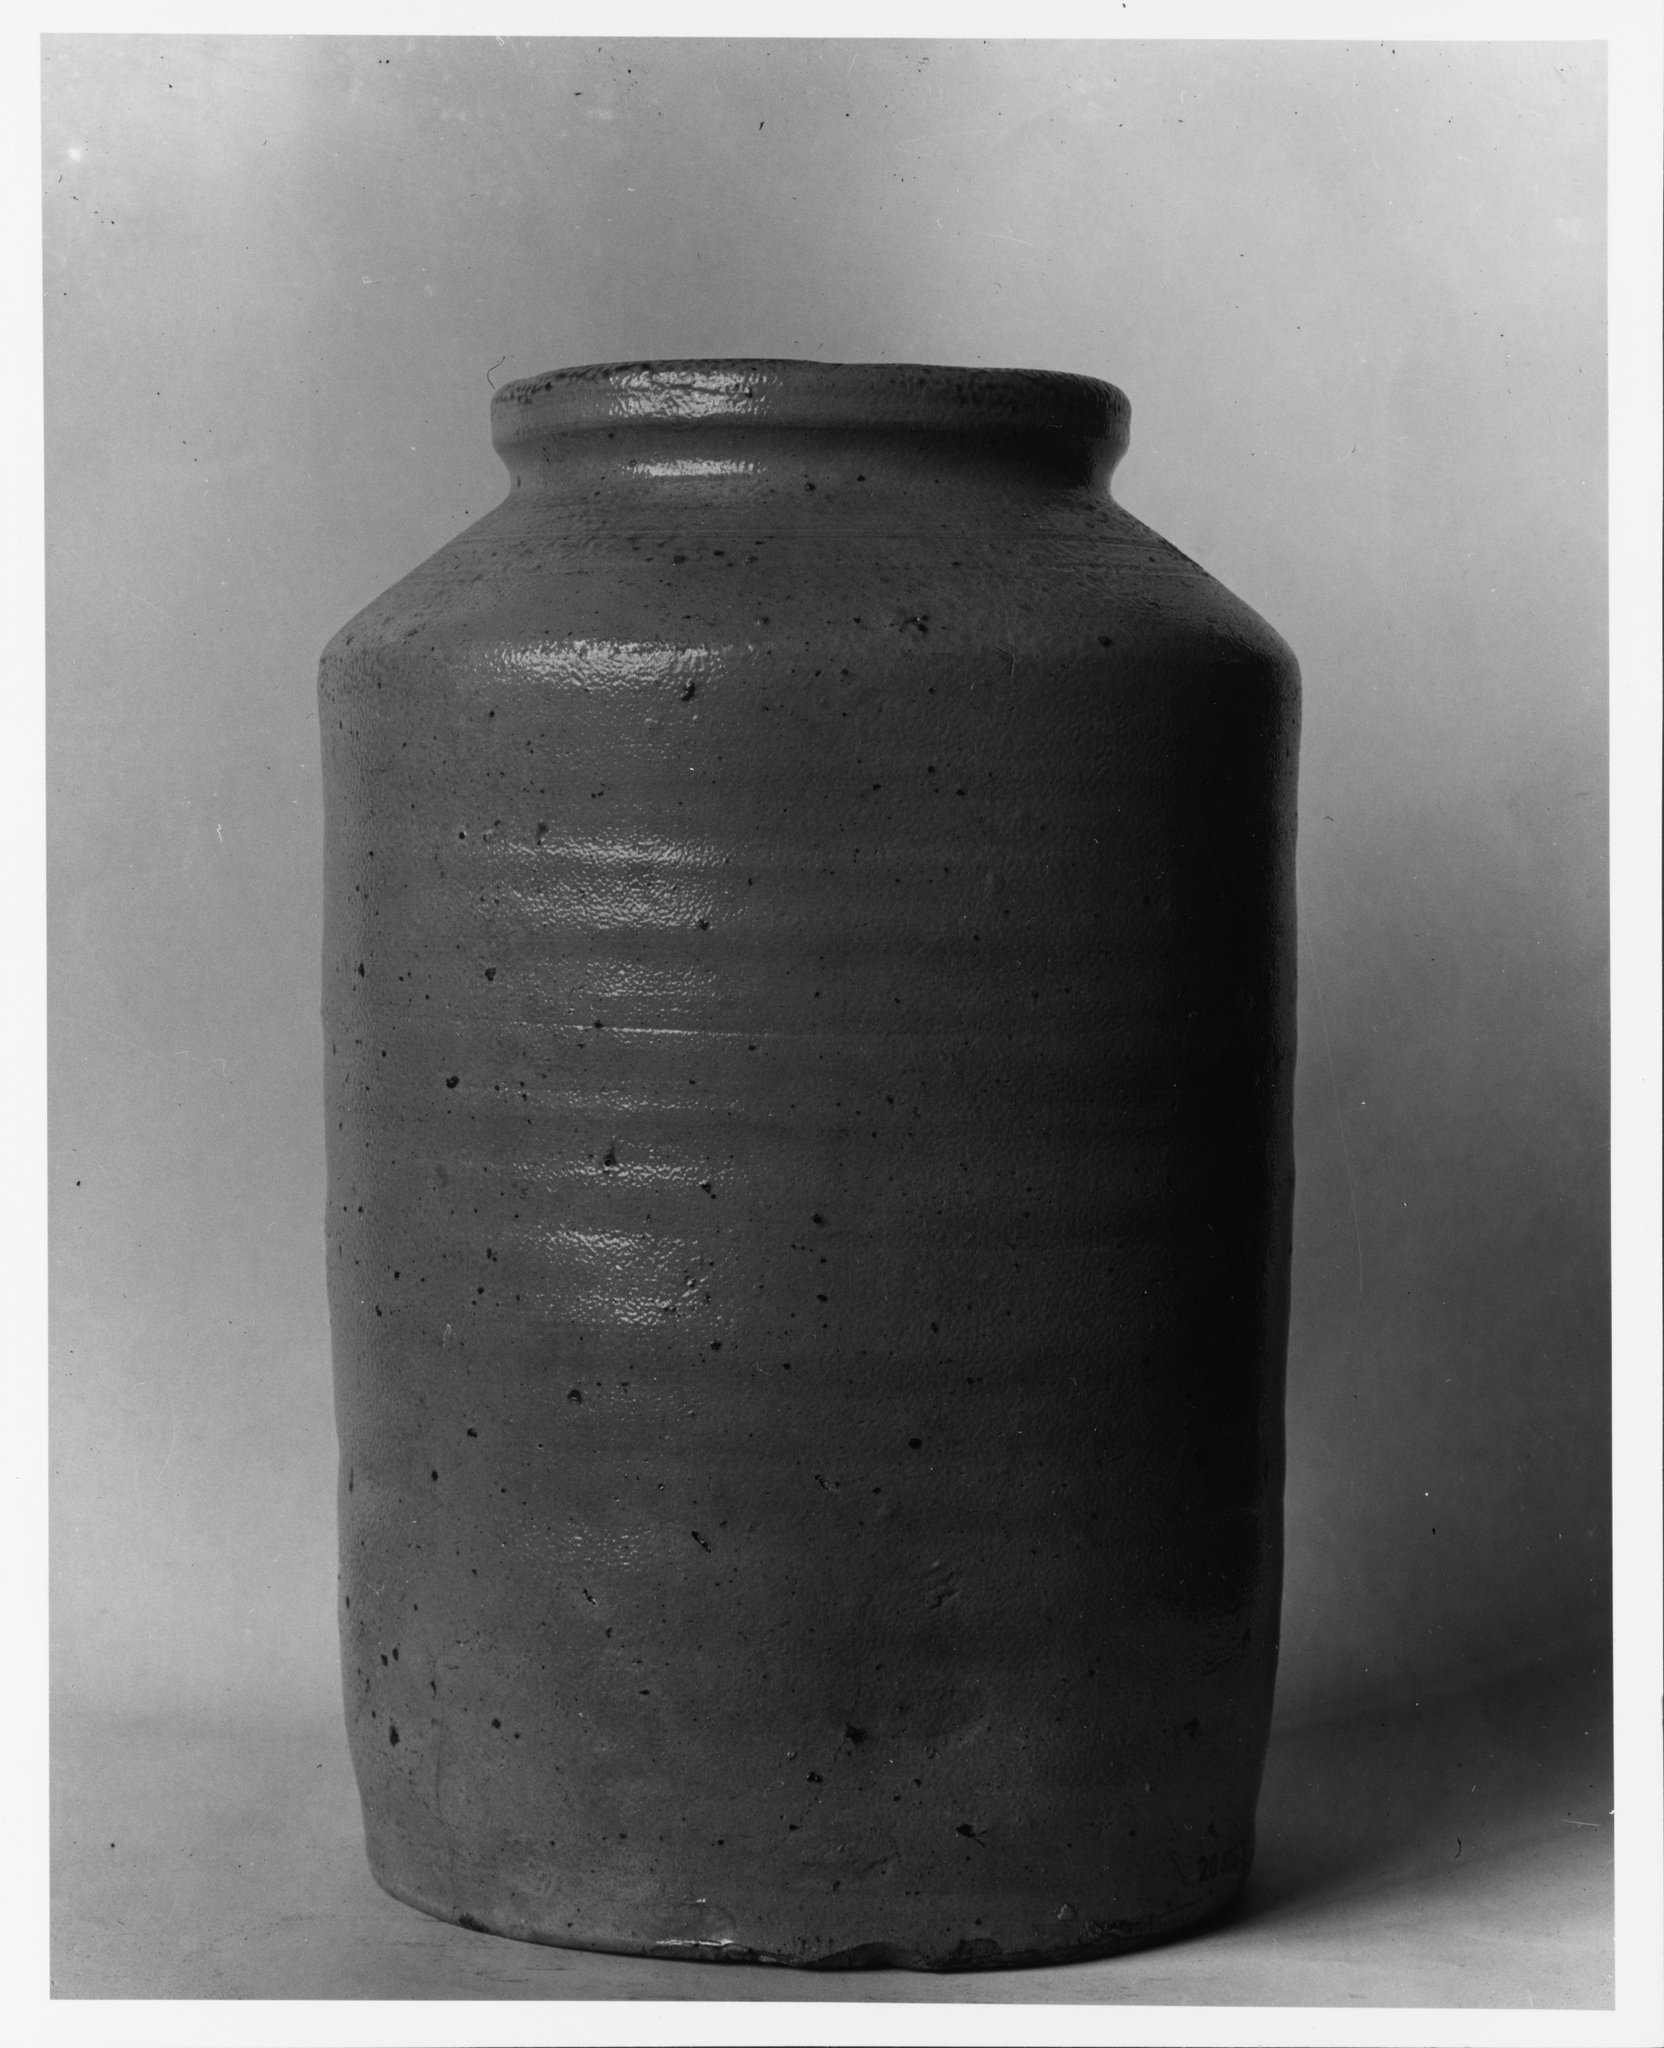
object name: jar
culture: american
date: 1800-1870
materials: stoneware